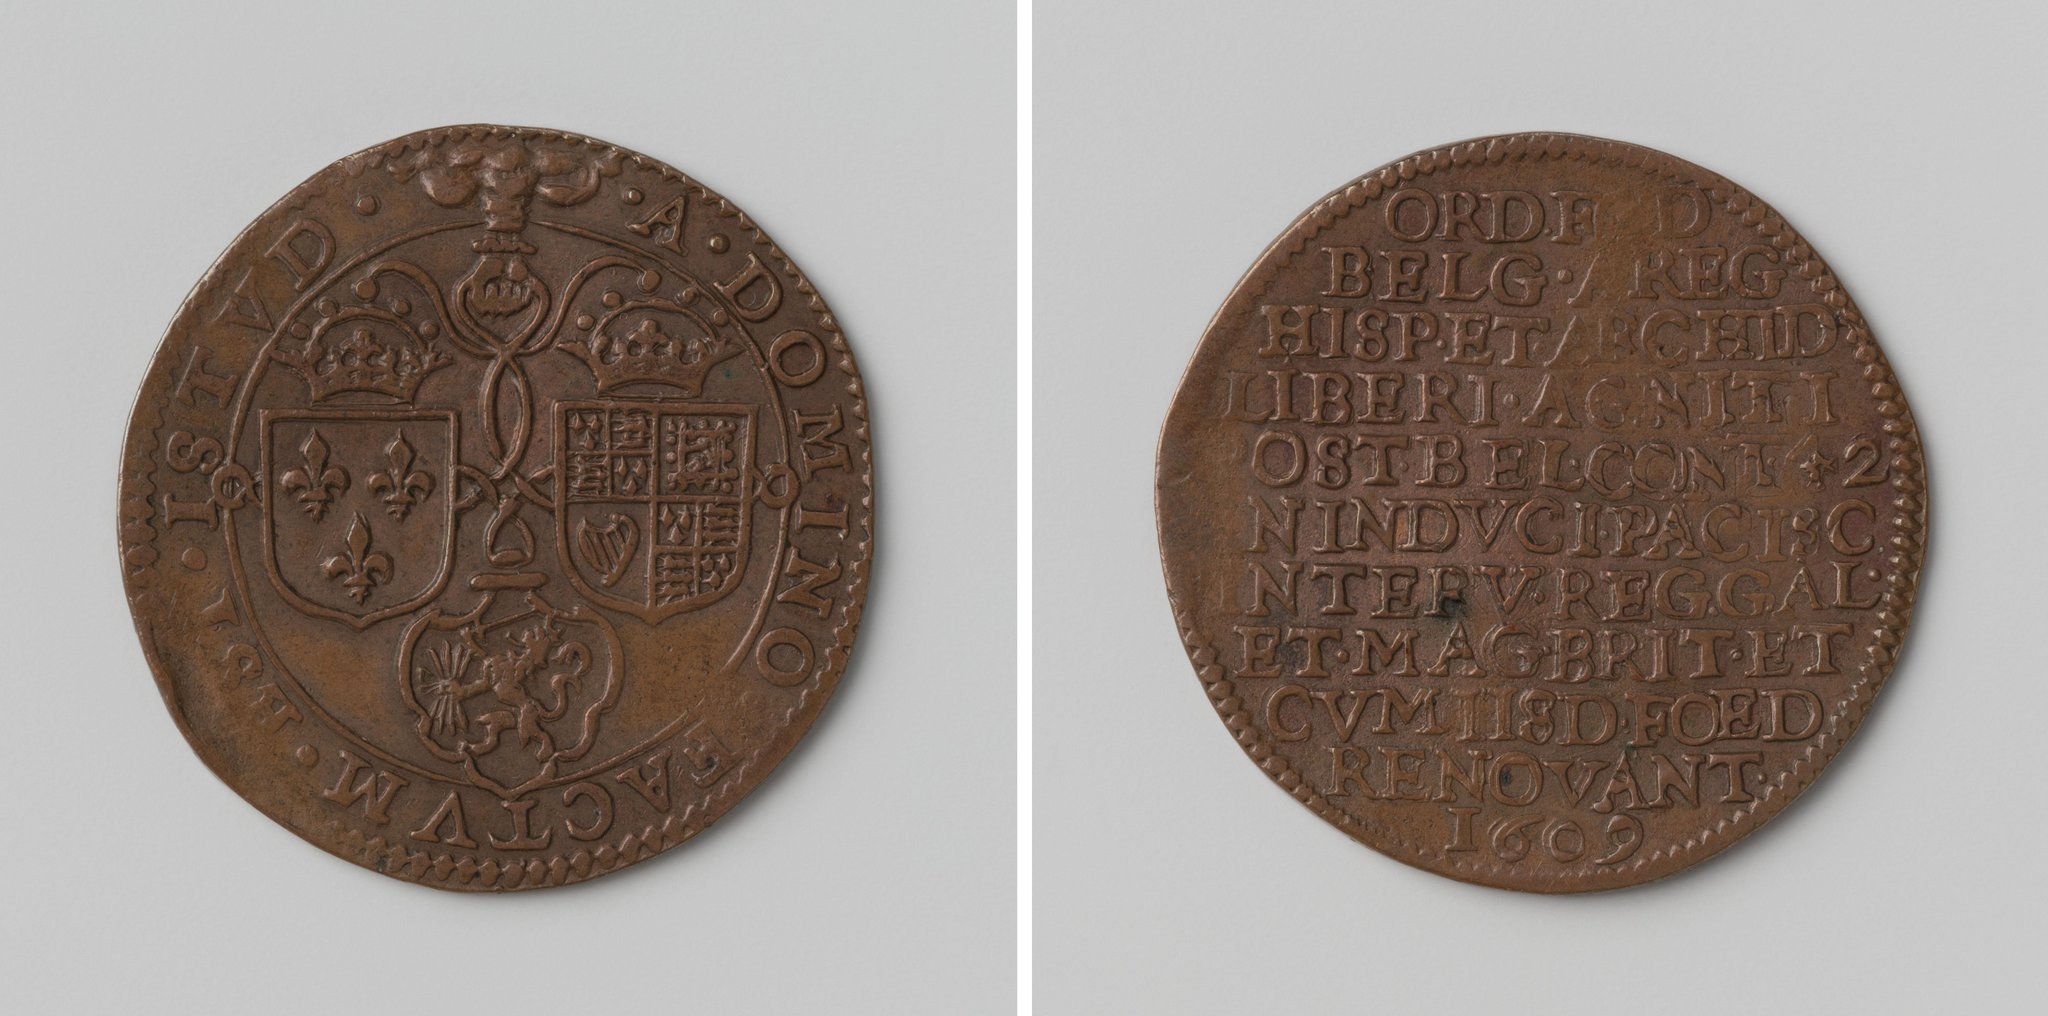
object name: jeton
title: Sluiting van het Twaalfjarig Bestand tussen de Republiek en Spanje, en hernieuwing van het drievoudige verbond tussen Engeland, Frankrijk en de Republiek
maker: Anonymous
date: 1609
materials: copper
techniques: striking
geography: netherlands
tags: netherlands, france, england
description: Koperen penning. Voorzijde: hand uit wolken houdt lint vast, waaraan een ongekroond en twee gekroonde wapenschilden hangen binnen omschrift. Keerzijde: opschrift.